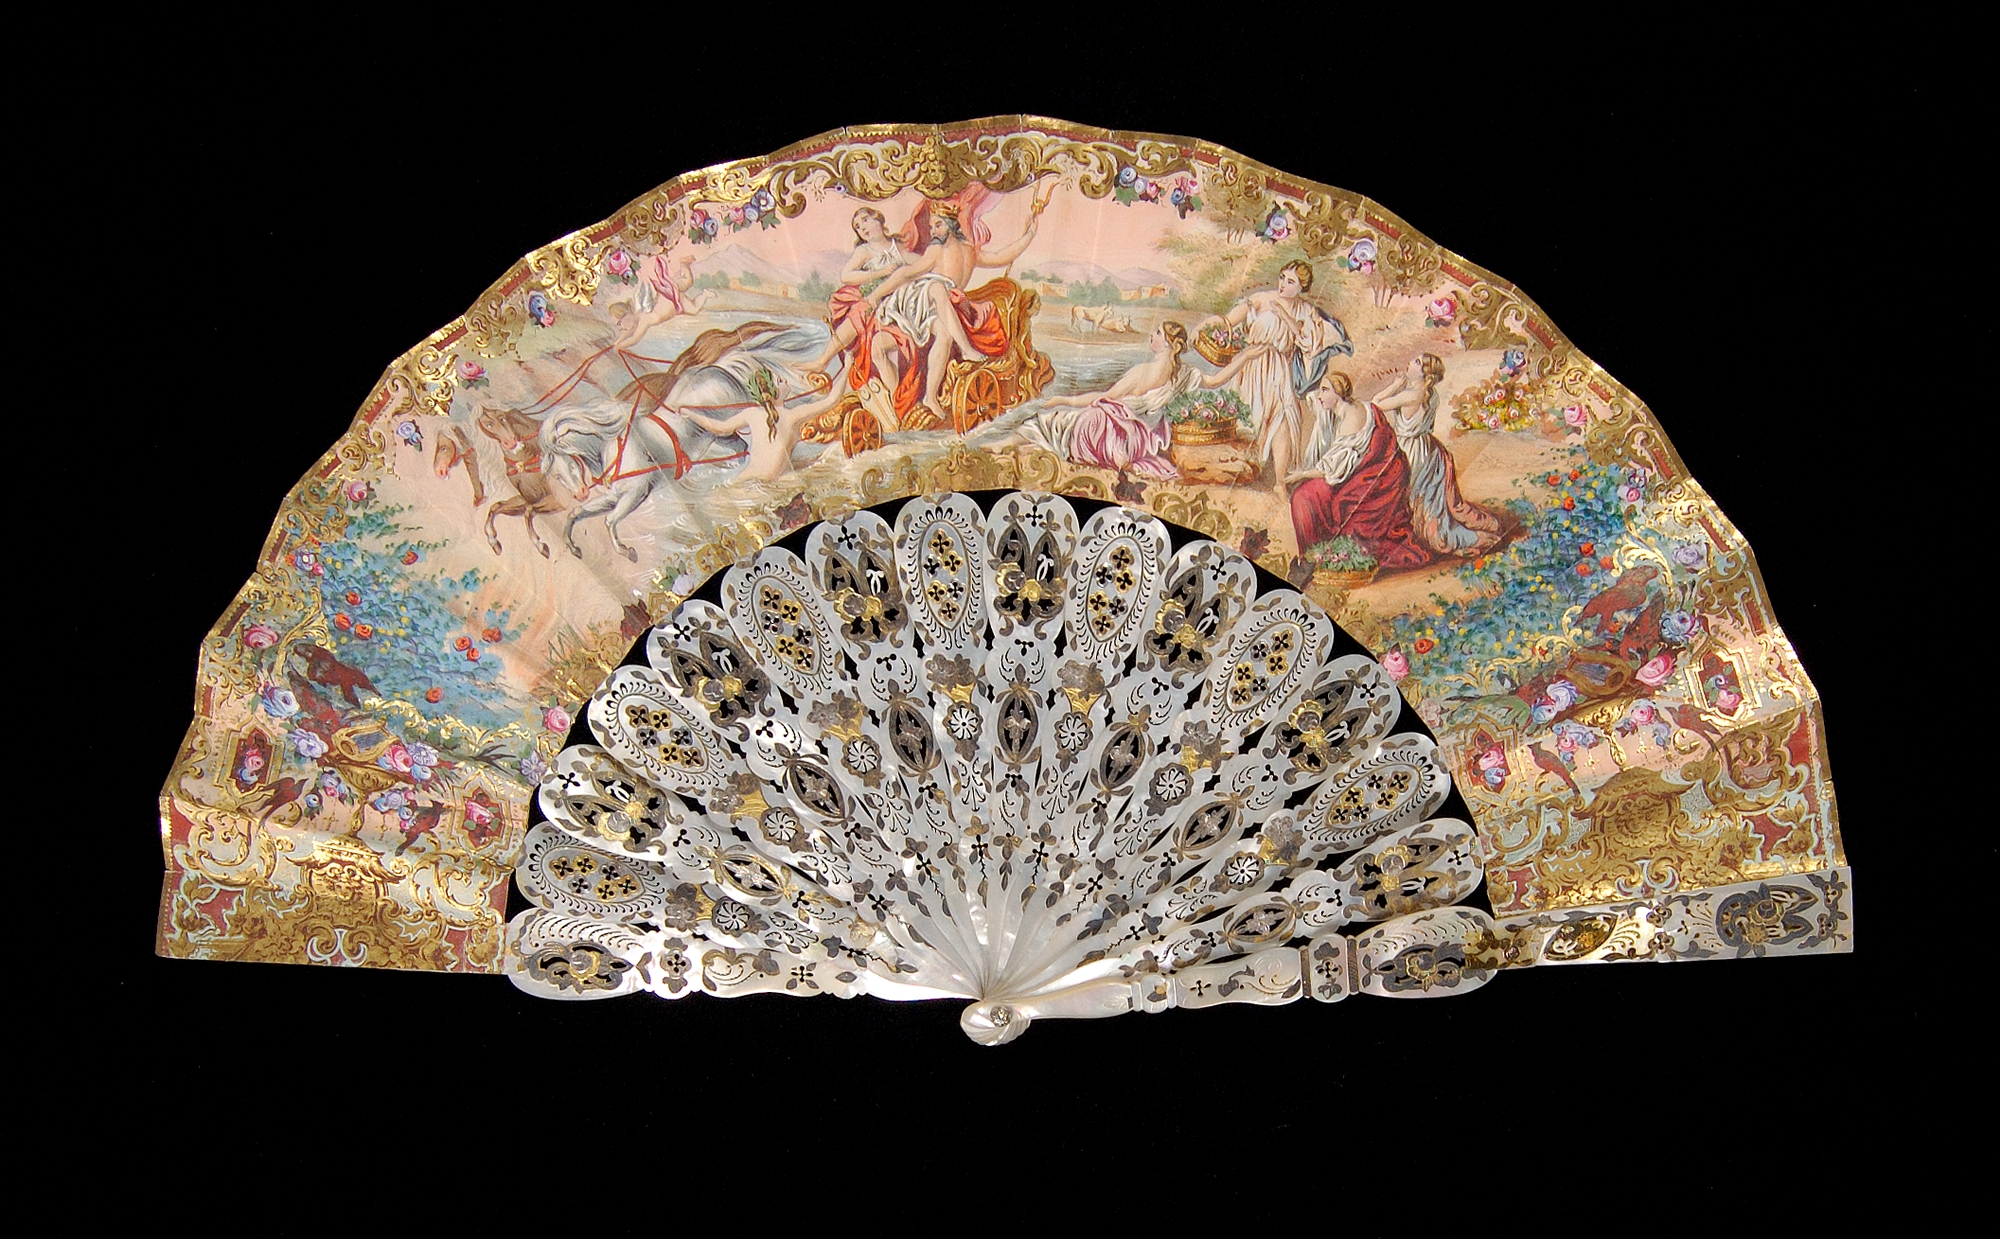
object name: fan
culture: european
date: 1855-1865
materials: mother of pearl, paper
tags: men,women,horses,chariots